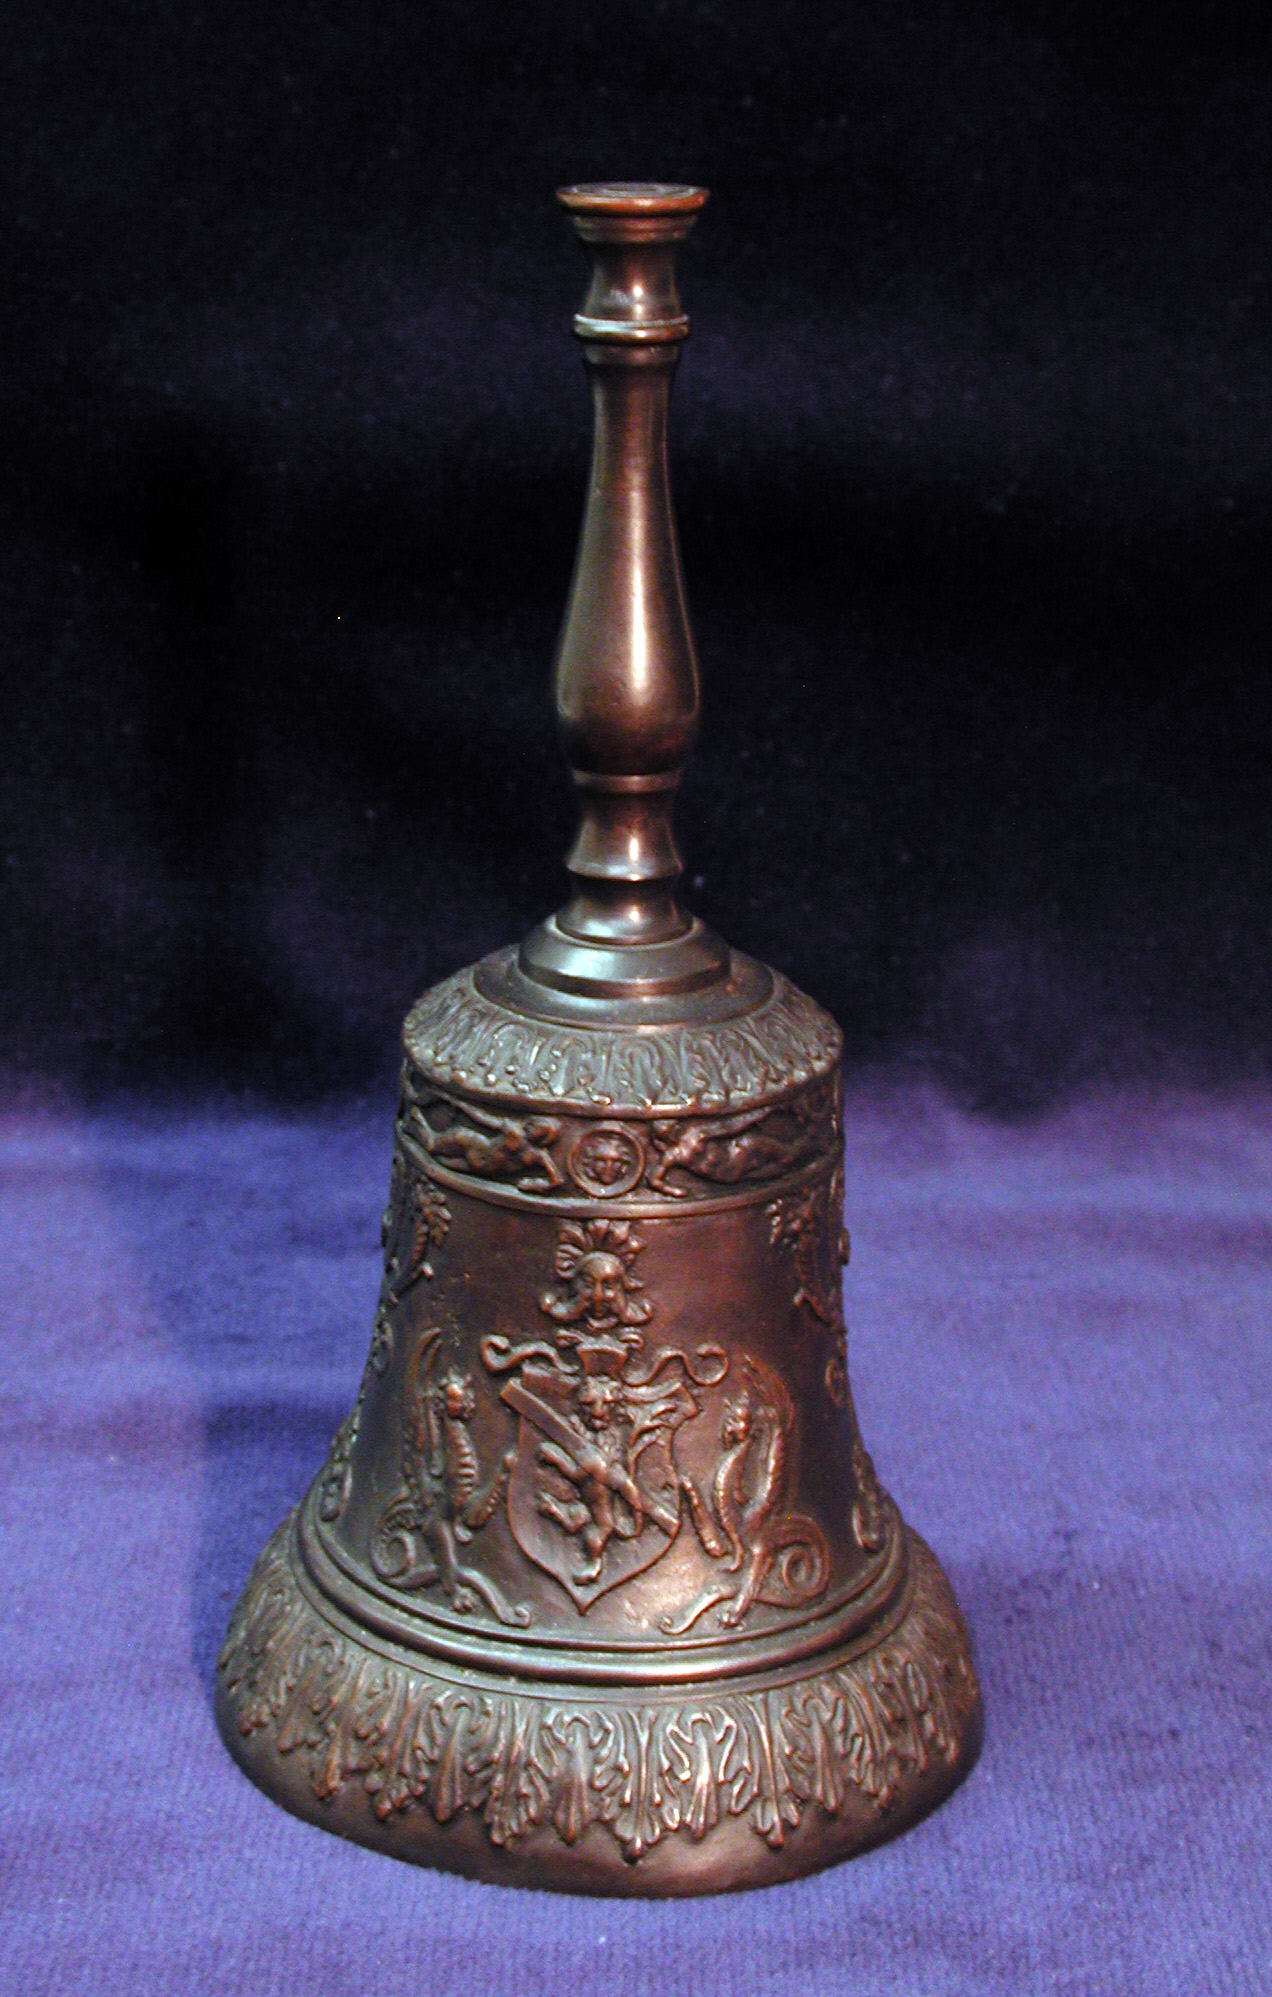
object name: bell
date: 1801-1900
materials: bronze, metal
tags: musical instruments,coat of arms